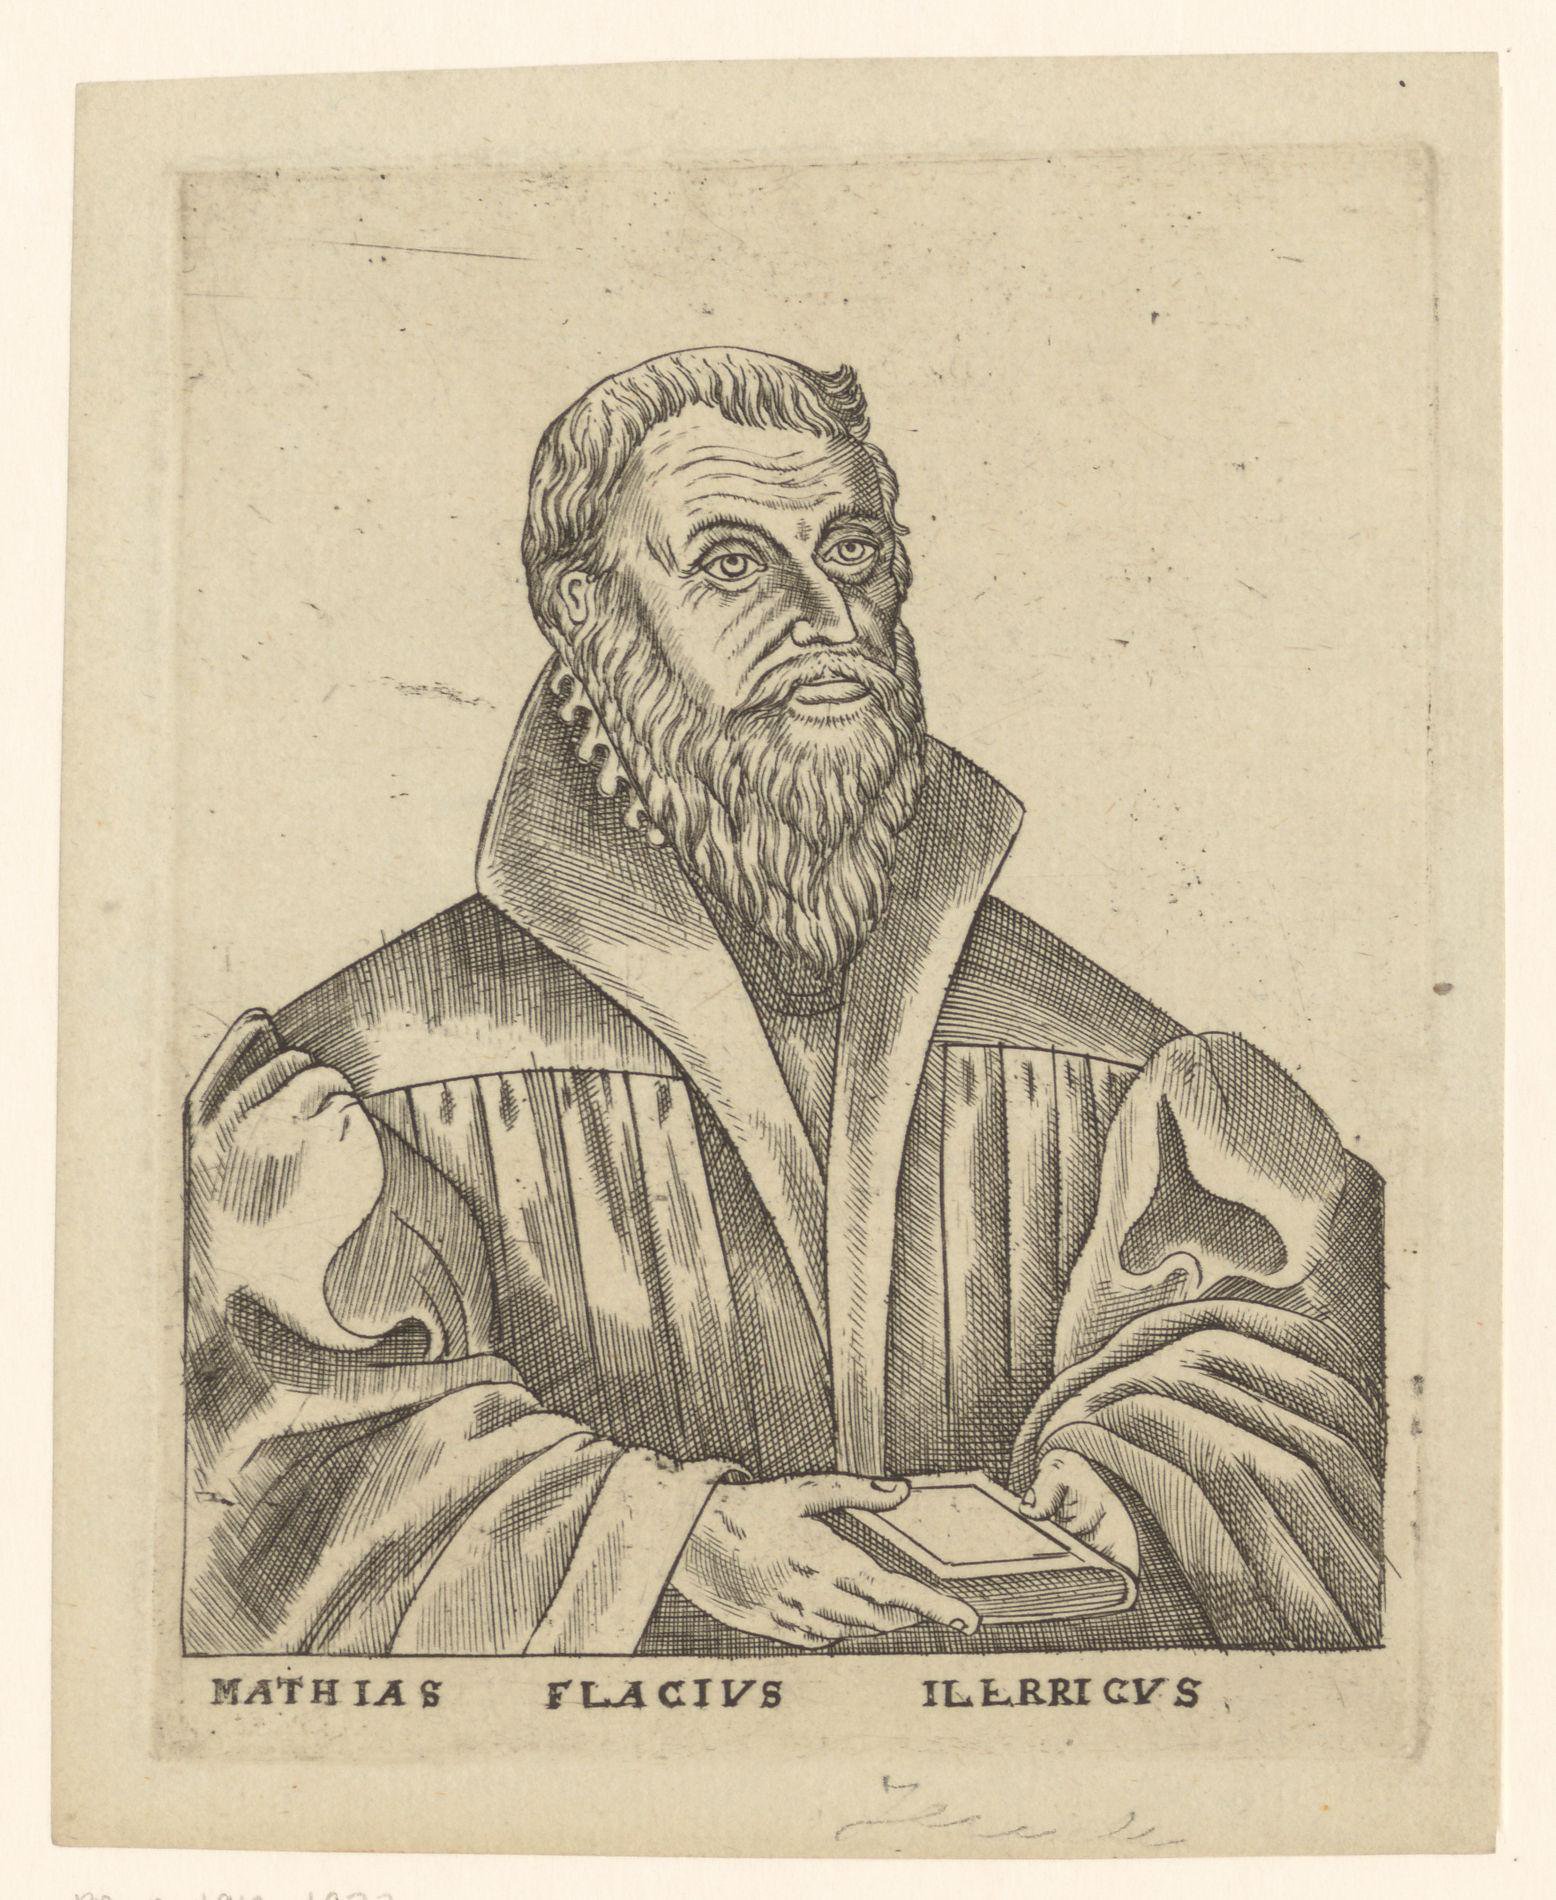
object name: print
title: Portret van Matthias Flacius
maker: Anonymous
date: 1563-1642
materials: paper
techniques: engraving, etching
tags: theologian, historical persons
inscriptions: collector's mark: Lugt 2228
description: Deze prent (een impressie) hoort bij een serie portretten van sturende personen tijdens de reformatie.